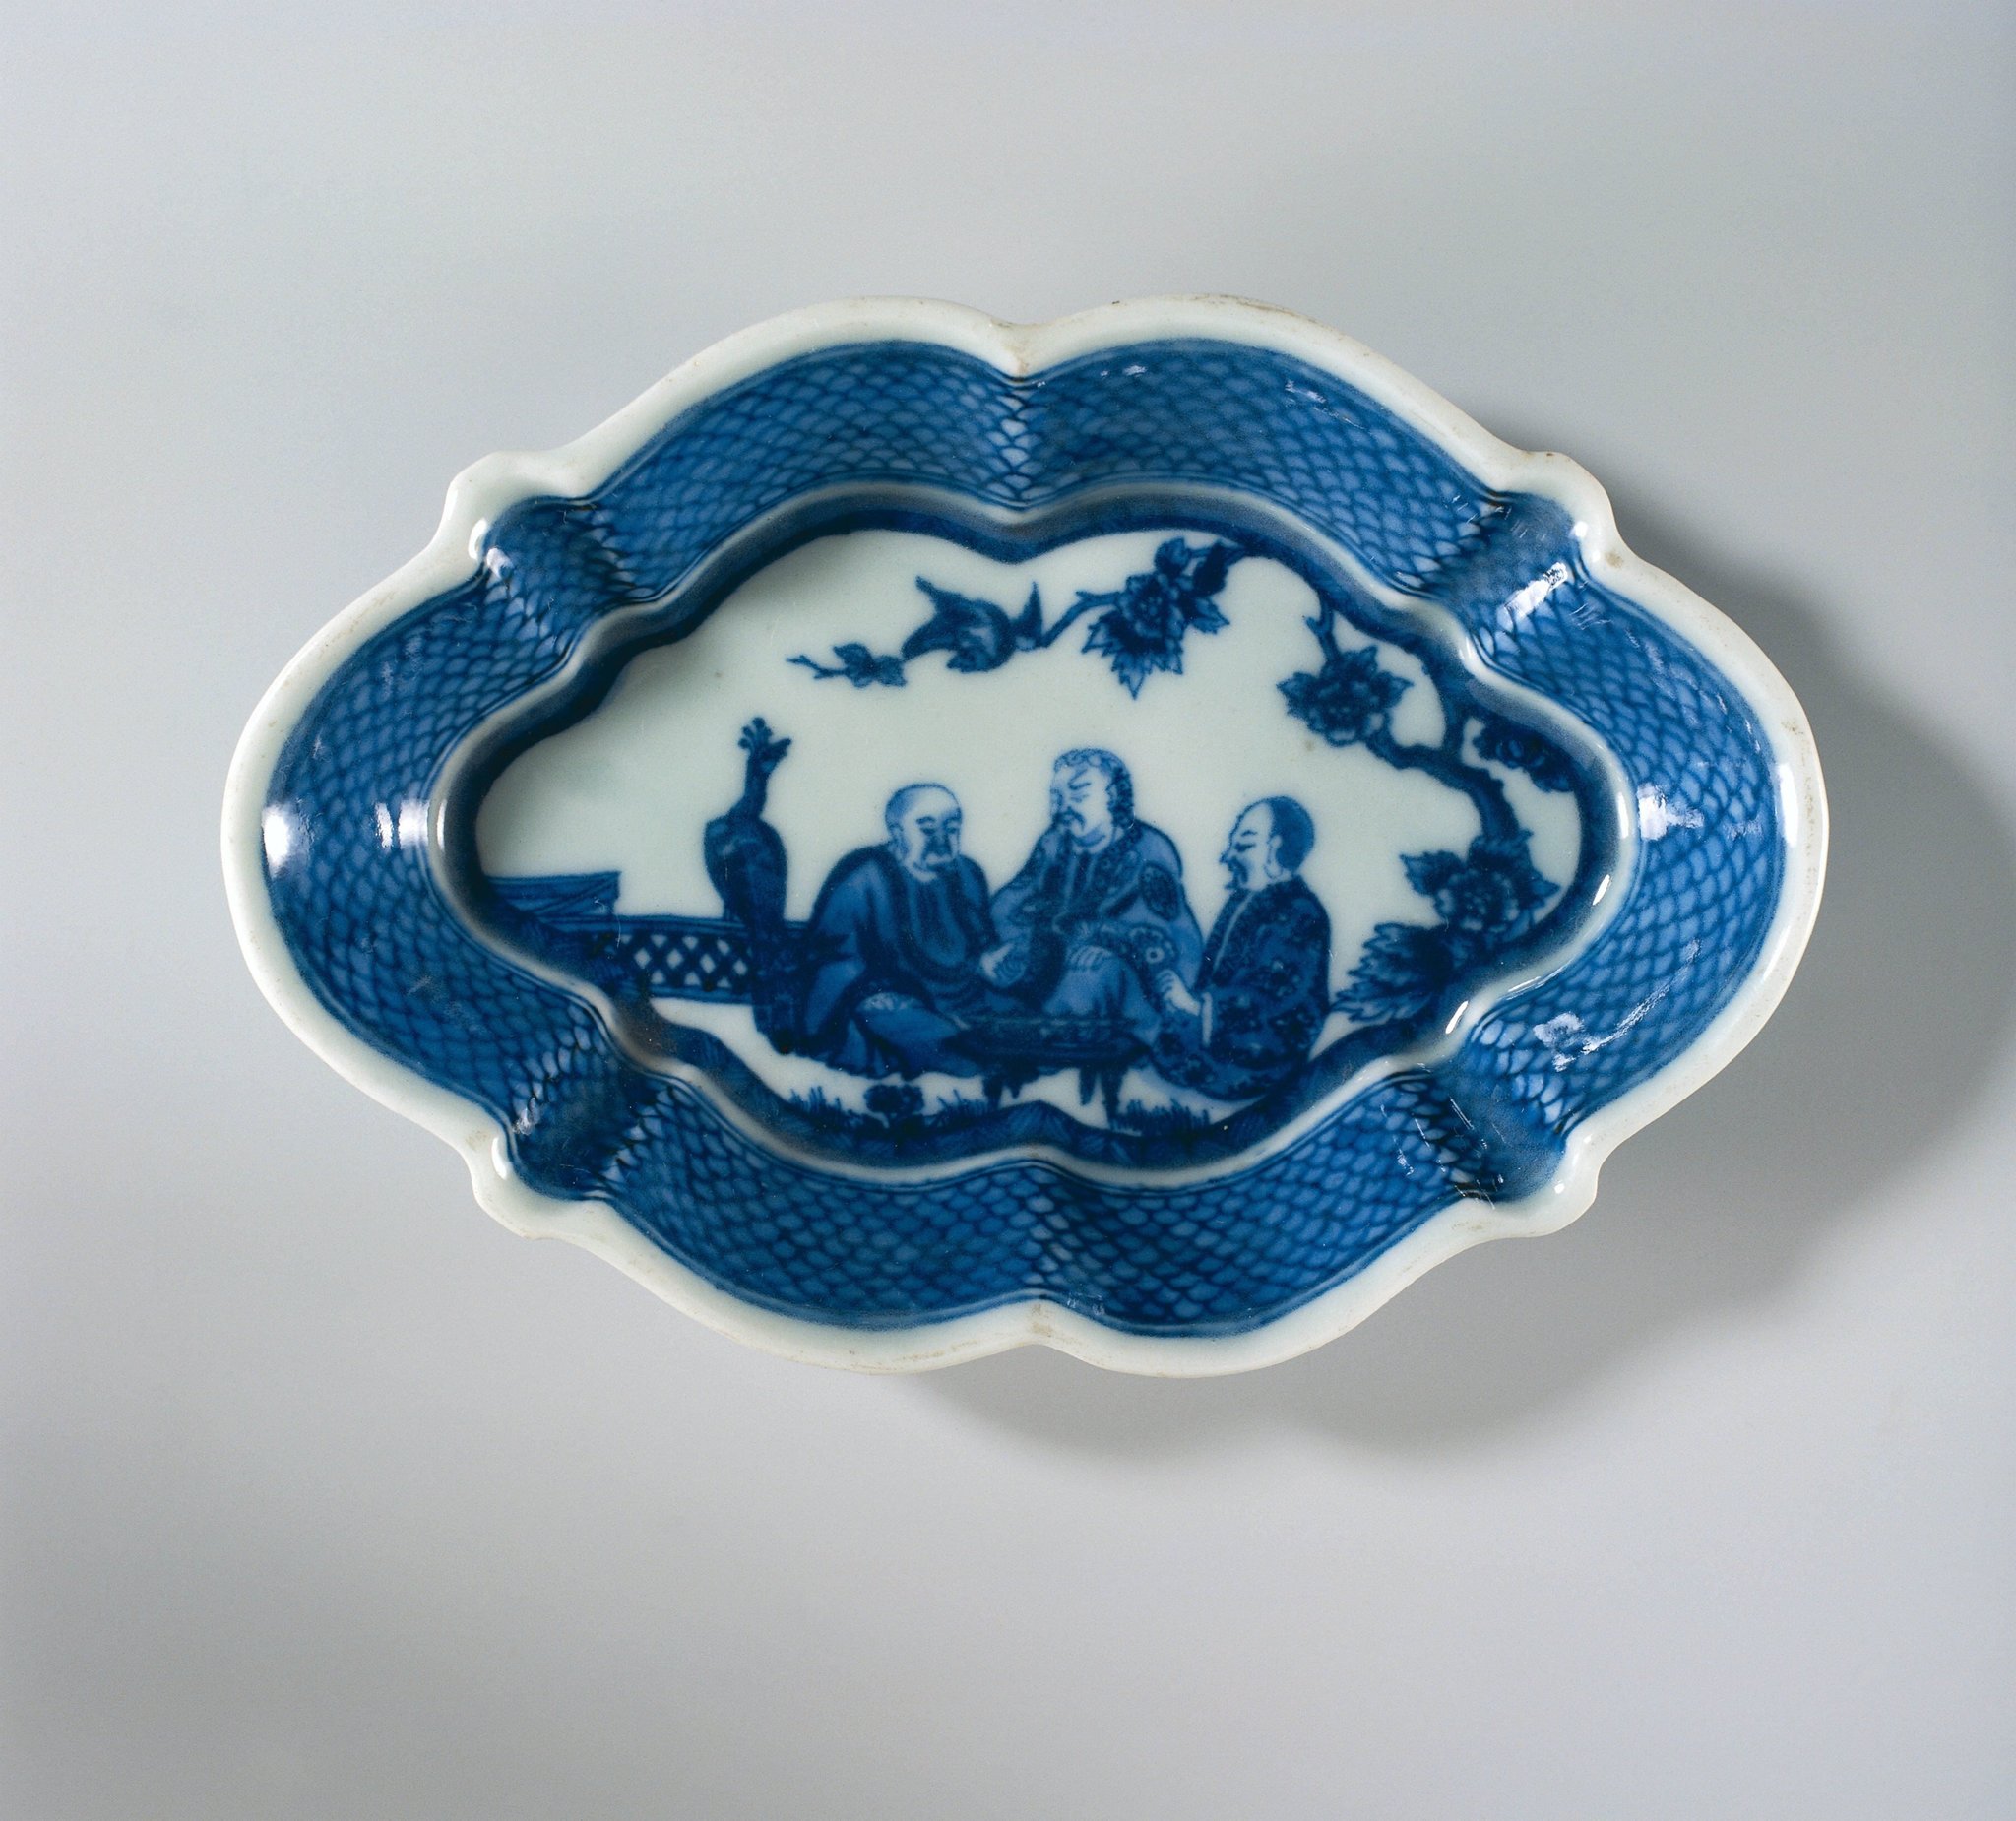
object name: pattipan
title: Pattipan (Stand for a Jug)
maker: Anonymous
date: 1740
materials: cobalt, glaze, paint, porcelain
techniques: firing, turning, vitrification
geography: netherlands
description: Designed by Cornelis Pronk (1691-1759), the depiction on this dish is known as ‘the three doctors.’ It might derive from the story of The Three Sages Tasting Vinegar about the poet Su Shi (1037-1101), the monk Foyin, and the Daoist Huang Tingjian (1045-1105). For Su vinegar tastes sour, for Foyin bitter, and for Huang sweet. This stands for the world views of Confucianism, Buddhism, and Taoism.